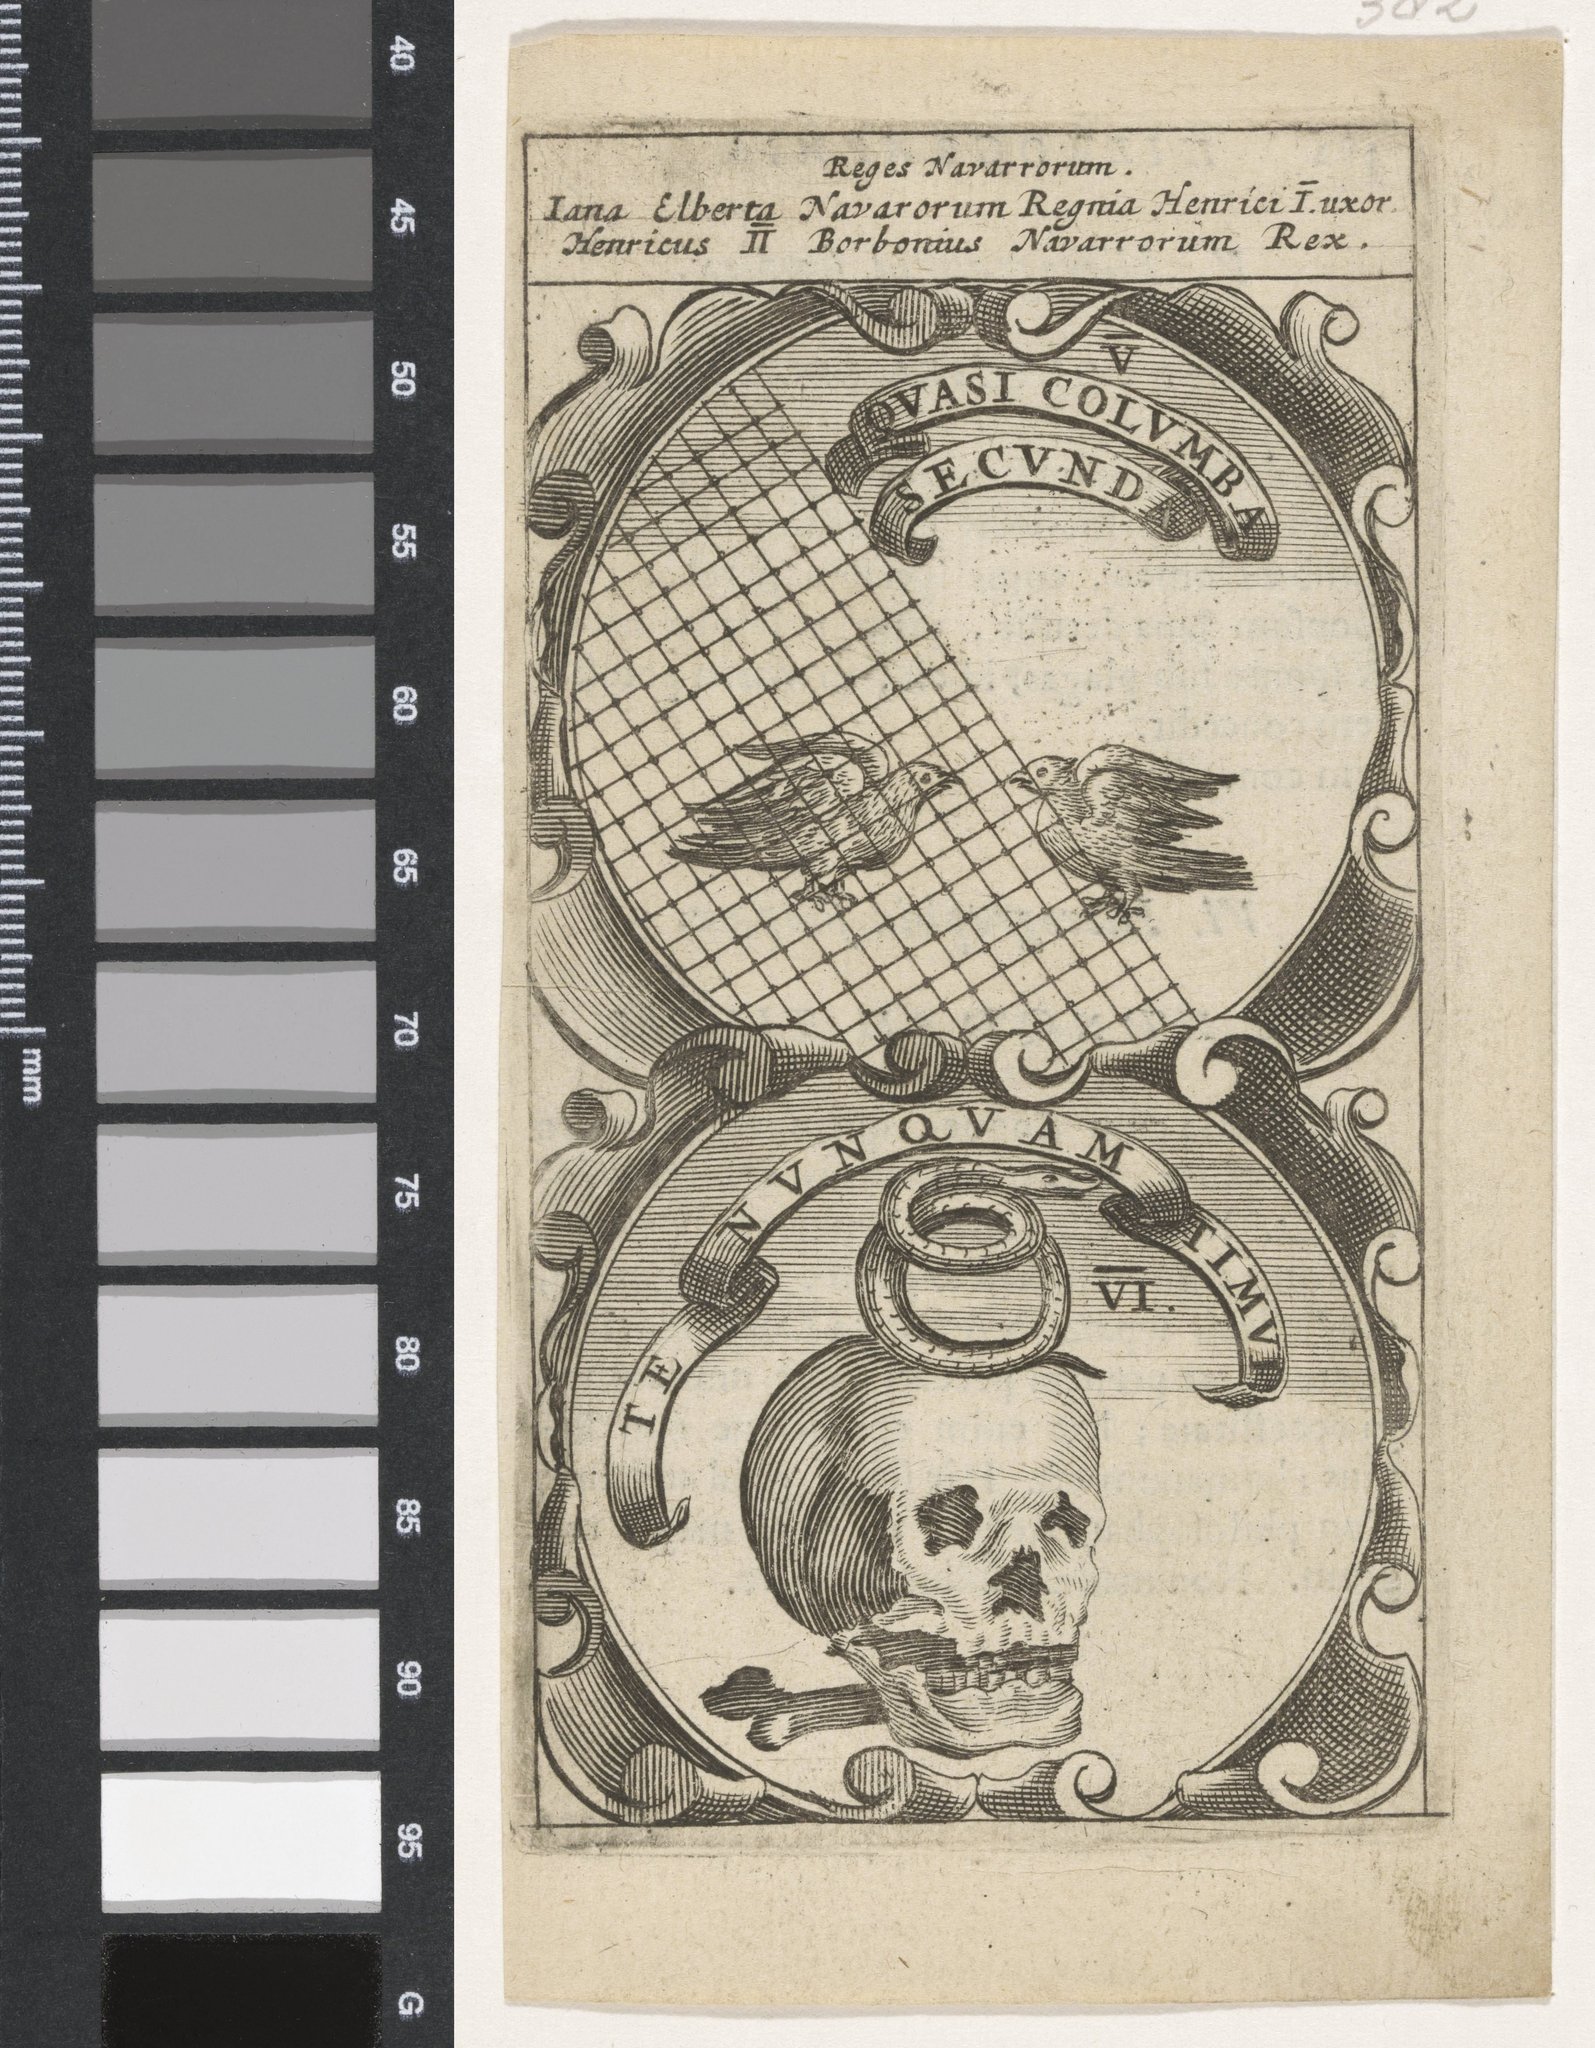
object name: book illustration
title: Symbola Divina et Humana Pontificum Imperatorum Regum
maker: Anonymous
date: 1666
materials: paper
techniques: engraving, letterpress printing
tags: paris, henri (prince of condé), snakes, other birds: dove, (human) skull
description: Pagina uit Jacob Typotius, Symbola Divina & Humana Pontificum Imperatorum Regum. Arnhem, J.F. Hagen, 1666 of uit de titeluitgave van 1669 of 1679. Het werk van Typotius werd voor het eerst uitgegeven in 1601 met prenten van Aegidius Sadeler.